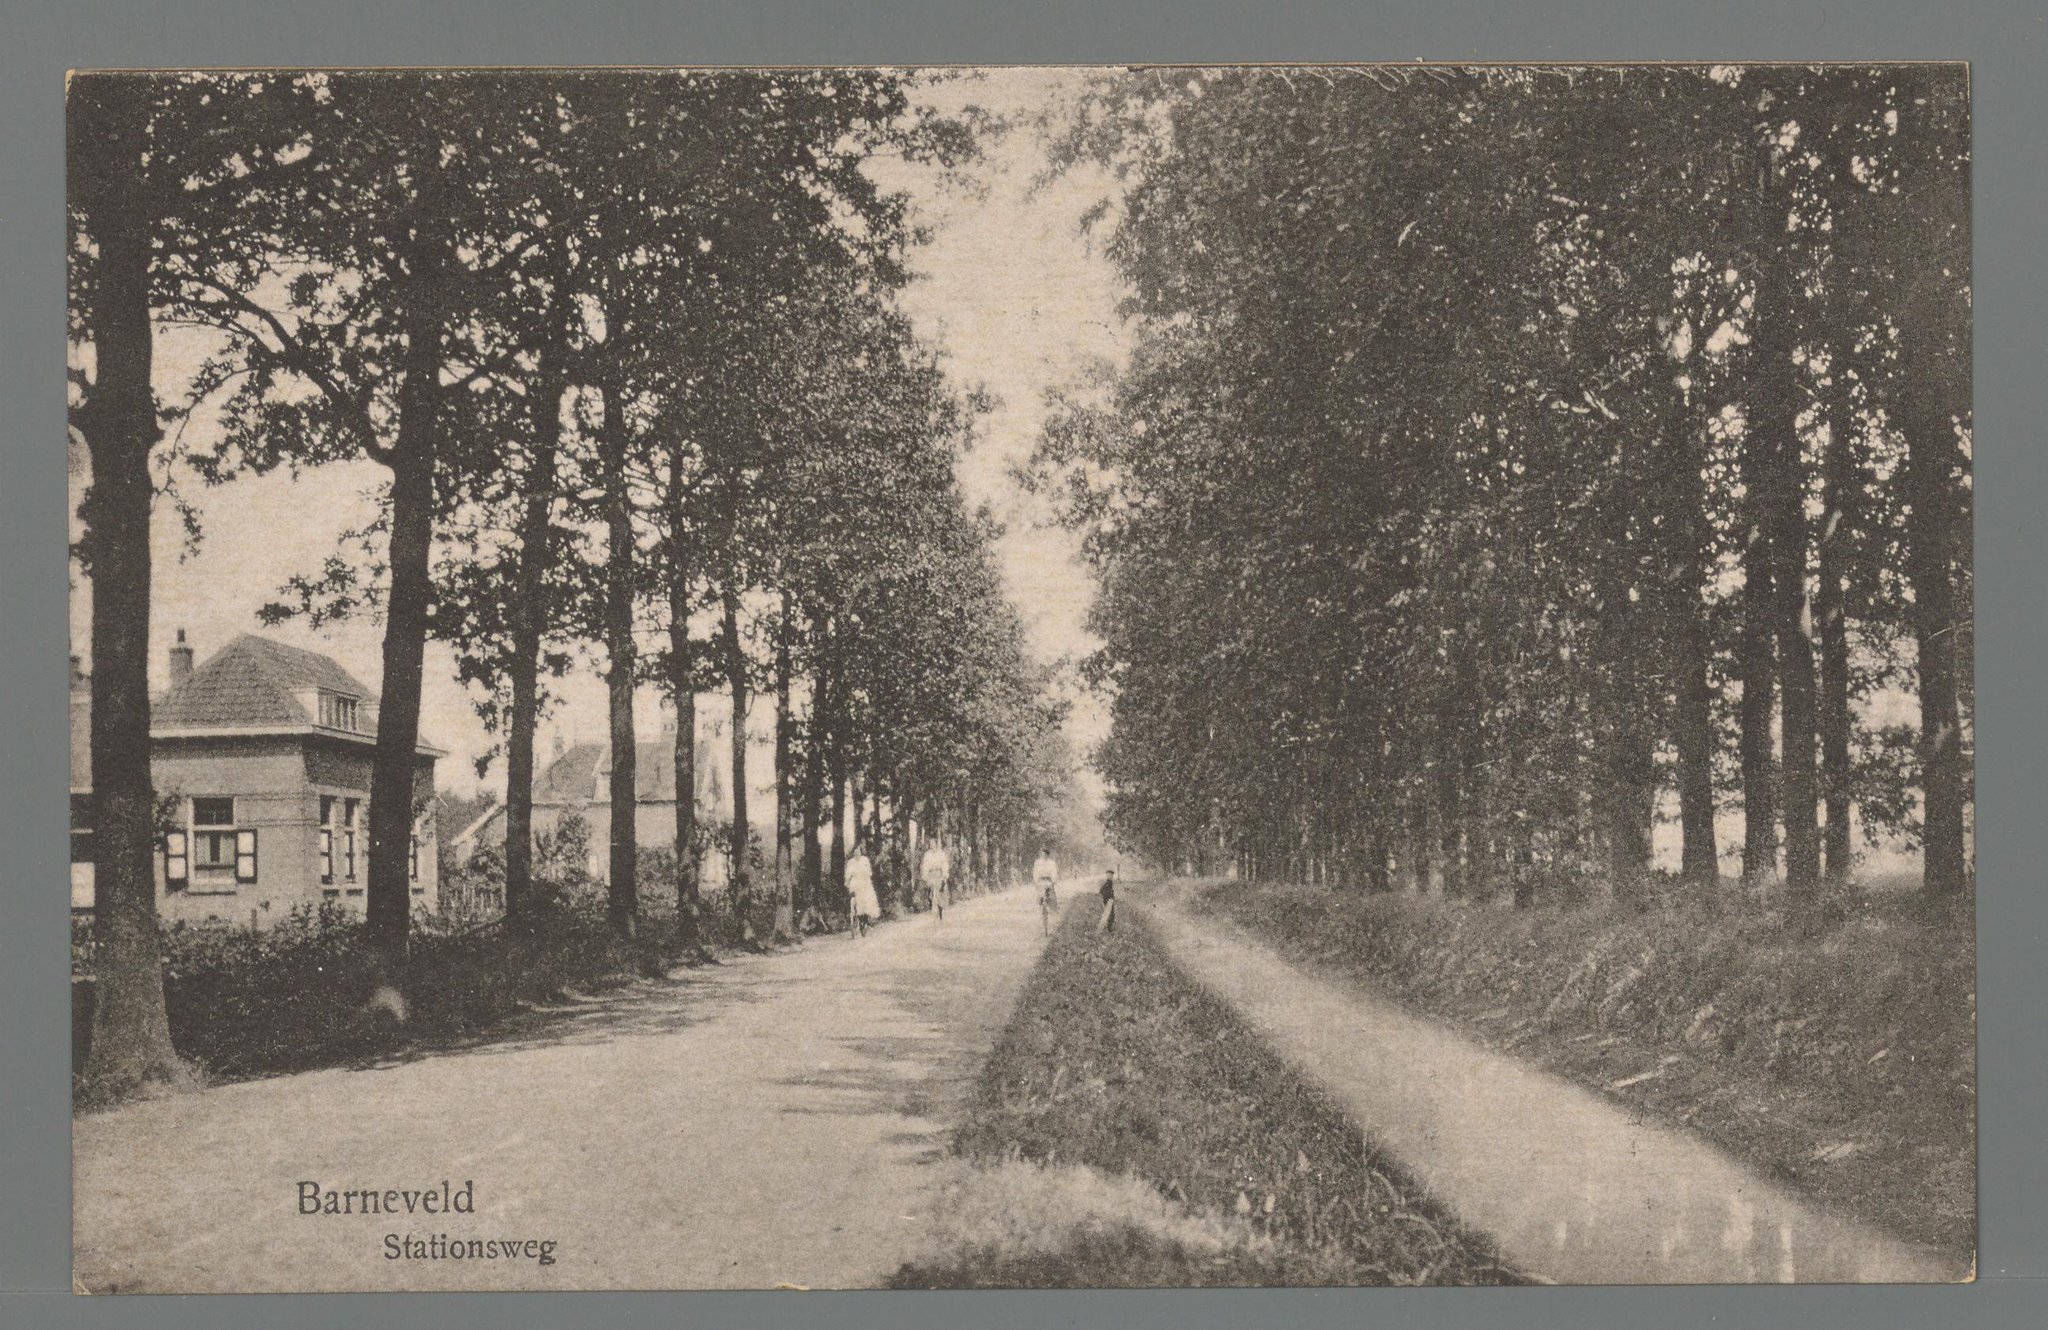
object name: ansichtkaart, prentbriefkaart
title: Barneveld. Stationweg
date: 1920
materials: cardboard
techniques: photograph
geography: barneveld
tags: canal, road, path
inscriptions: date